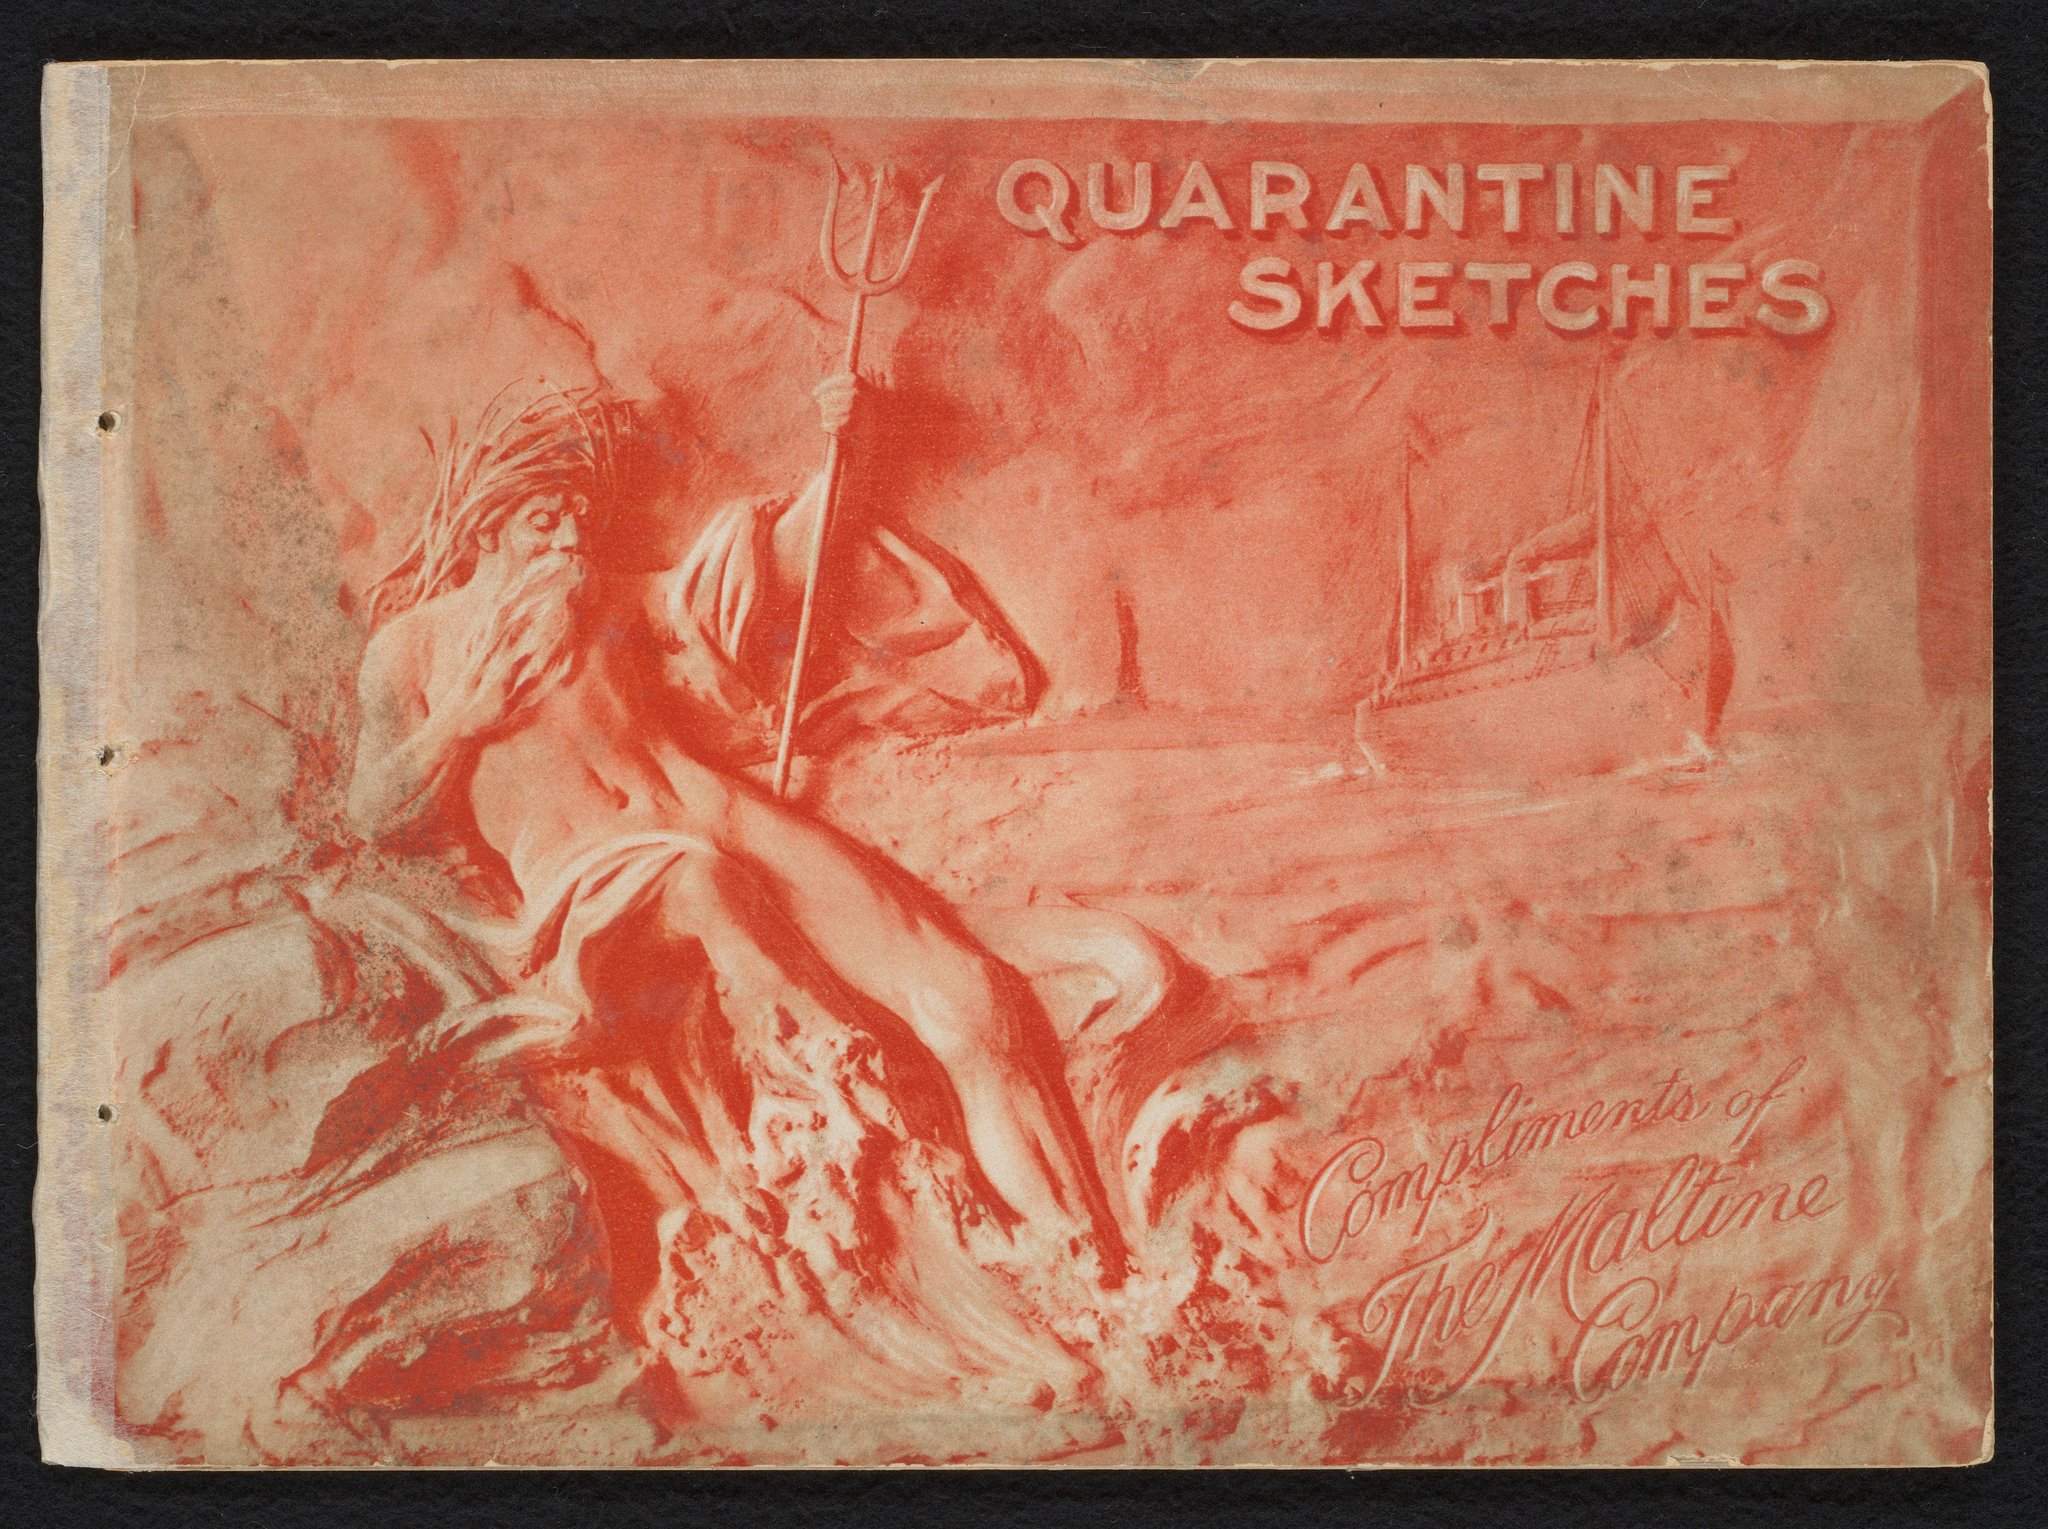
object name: book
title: Quarantine : glimpses of America's threshold / the Maltine Company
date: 1902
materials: paper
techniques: photograph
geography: new york city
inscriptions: inscription: ‘QUARANTINE SKETCHES/ Compliments of/ The Maltine Company’, date: ‘SEPT/ 2021’, number: ‘wo/ $40’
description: Boek met fotomechanische afdrukken van Europese migranten bij aankomst en tijdens medische inspectie in New York.